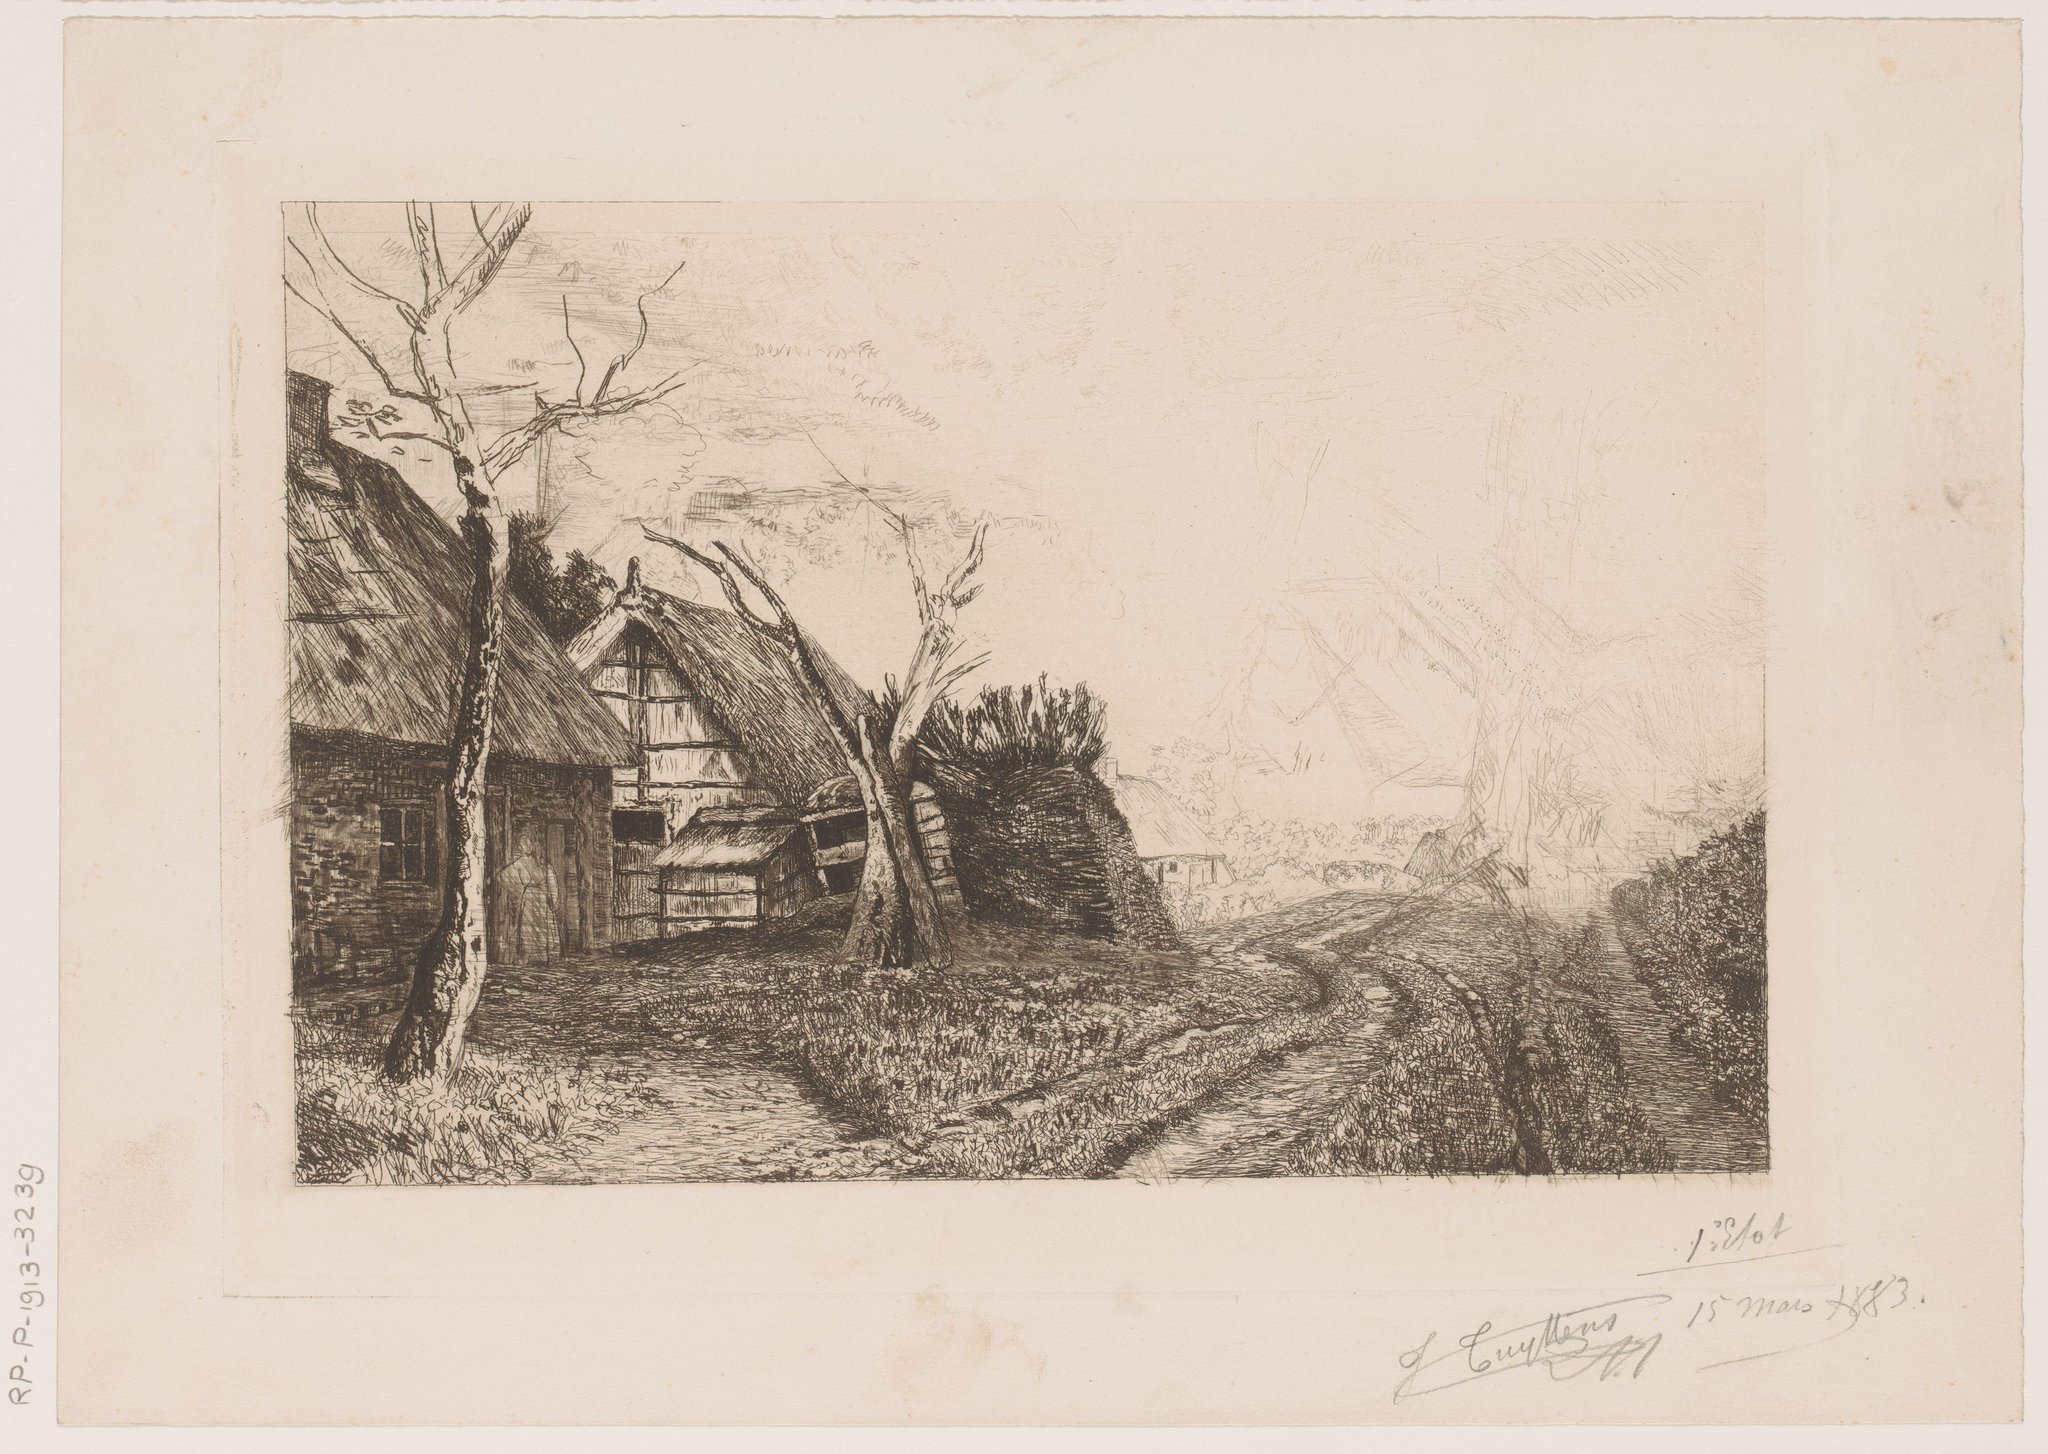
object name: print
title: Landschap met boerderijen en molen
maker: jerôme tuyttens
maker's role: painter, print maker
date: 1883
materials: paper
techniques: drypoint, etching, retroussage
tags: city-view, and landscape with man-made constructions, windmill, farm (building)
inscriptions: collector's mark: Lugt 2228, annotation: ‘1e Etat/ 15 mars 1883’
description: Sterfdatum van de prentmaker is onbekend. Daarom is voor de bepaling van de rechten van dit object gebruik gemaakt van de verwervingsdatum Rijksmuseum Amsterdam.